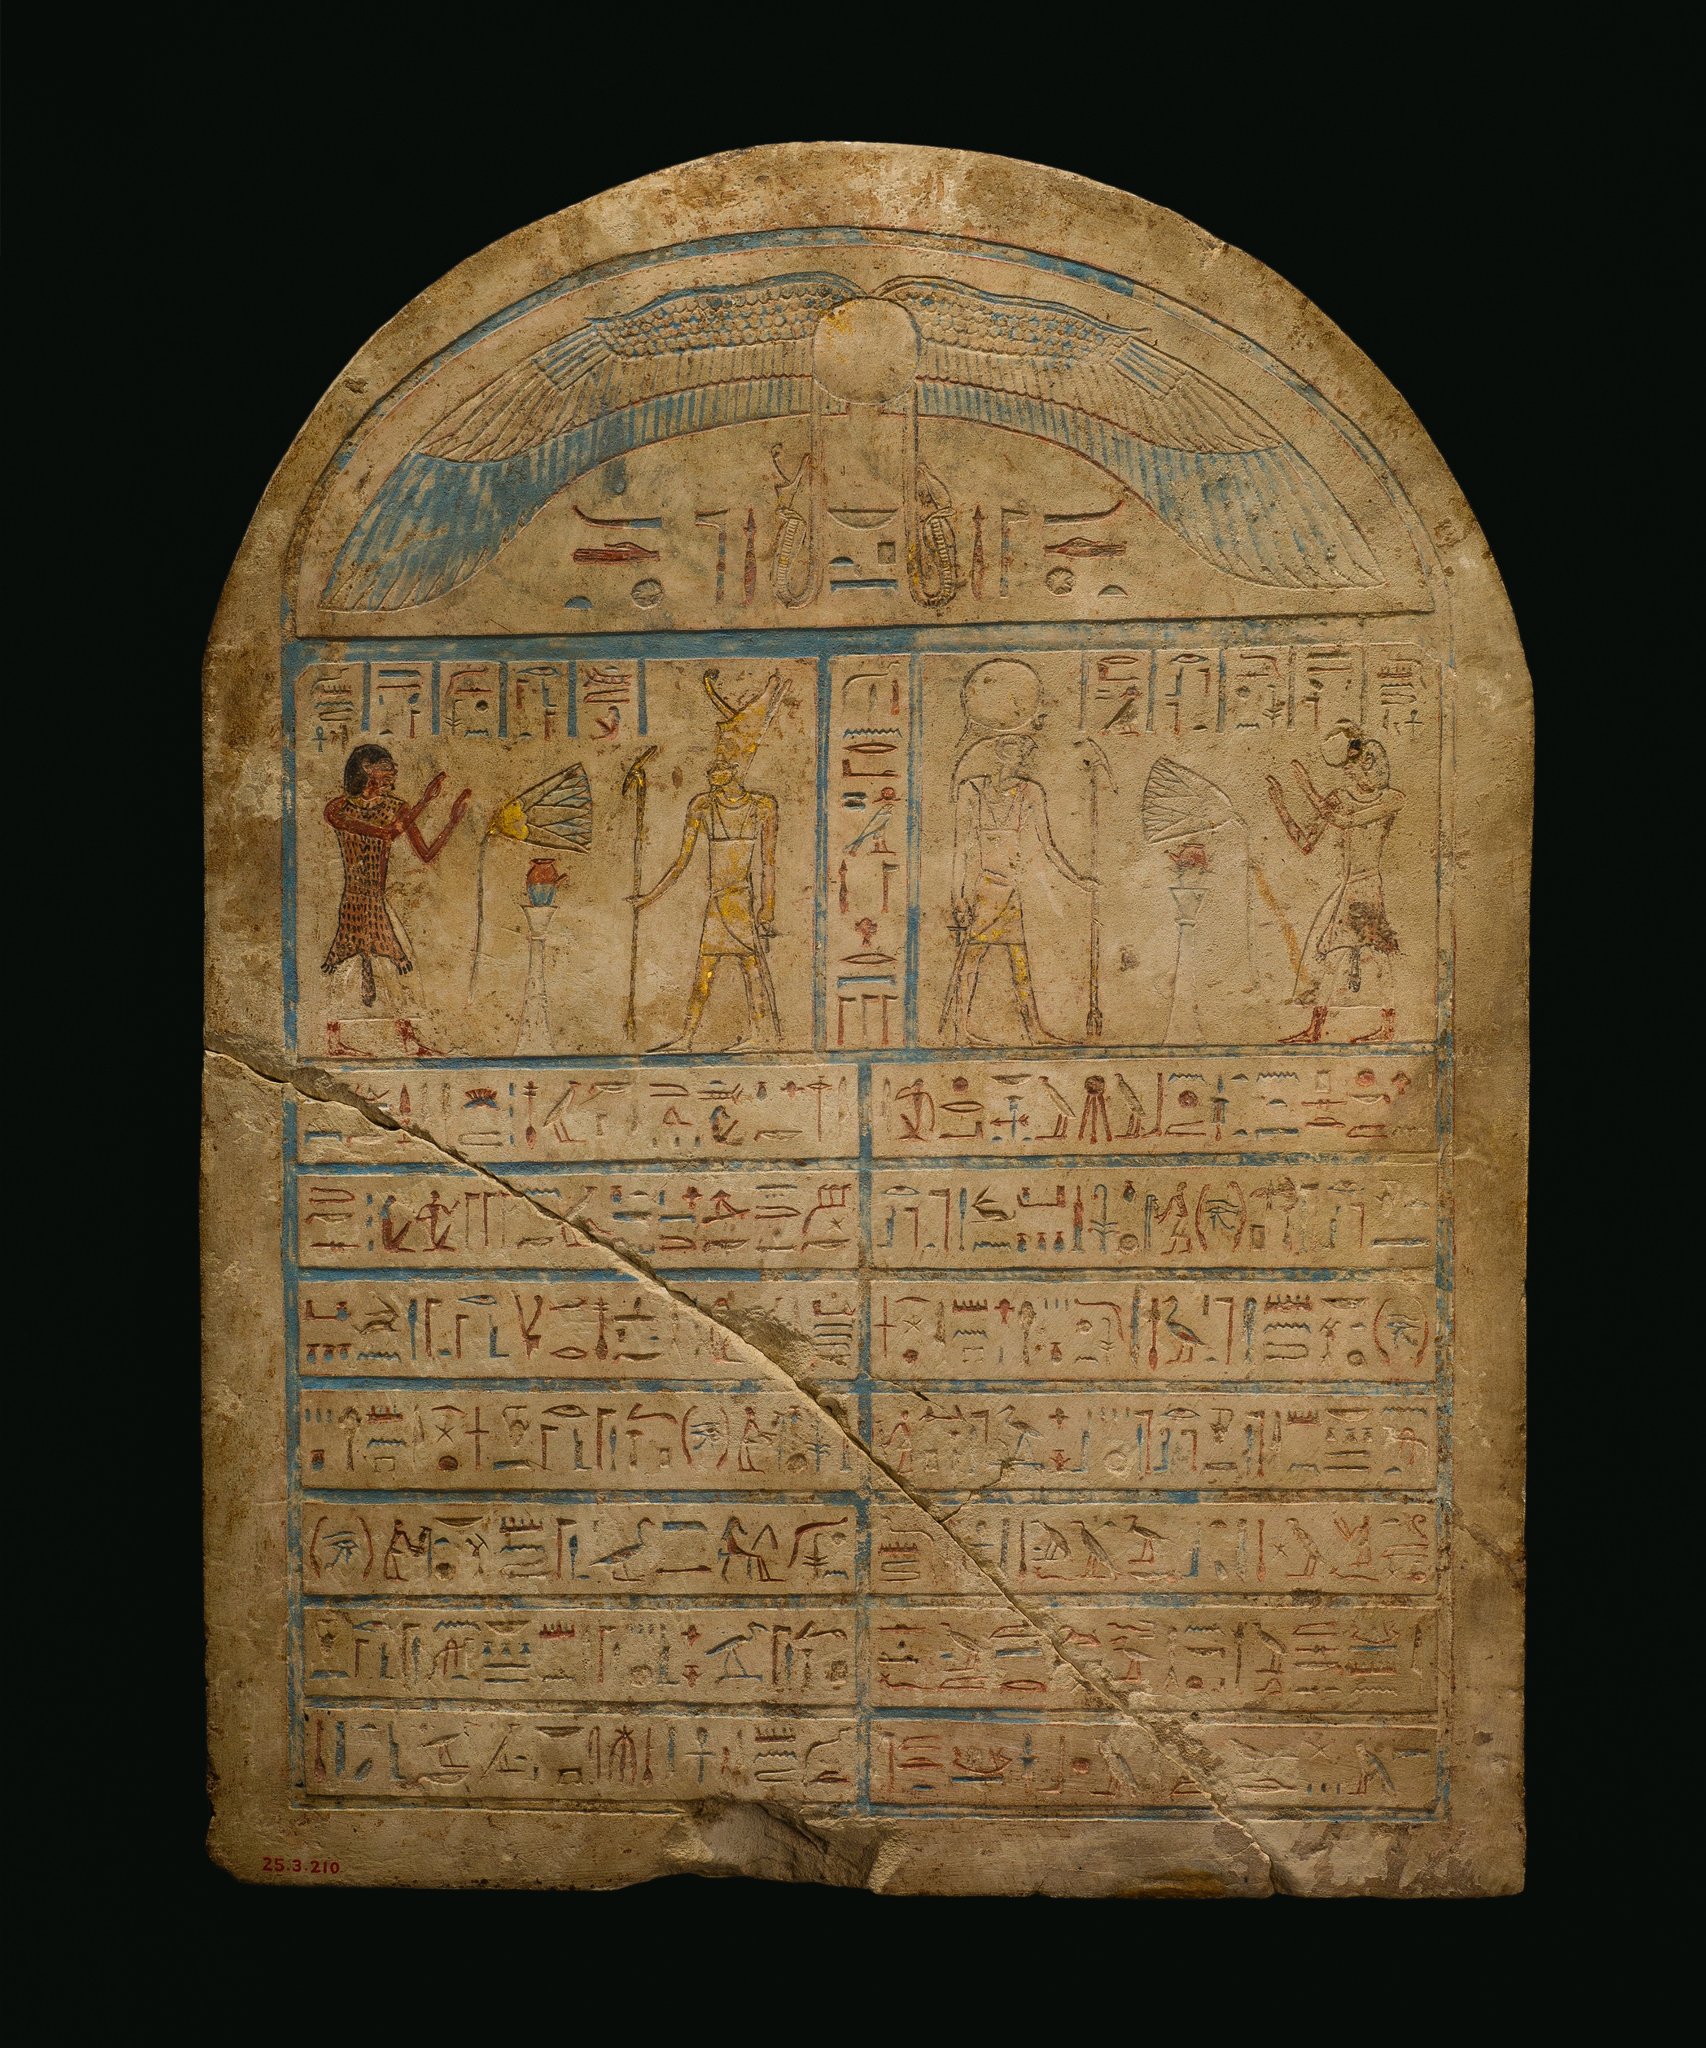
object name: stela, nesikhonsu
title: Funerary Stela of the God's-Father, Nesikhonsu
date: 664-525 BCE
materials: gold leaf, limestone, paint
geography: egypt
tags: hieroglyphs